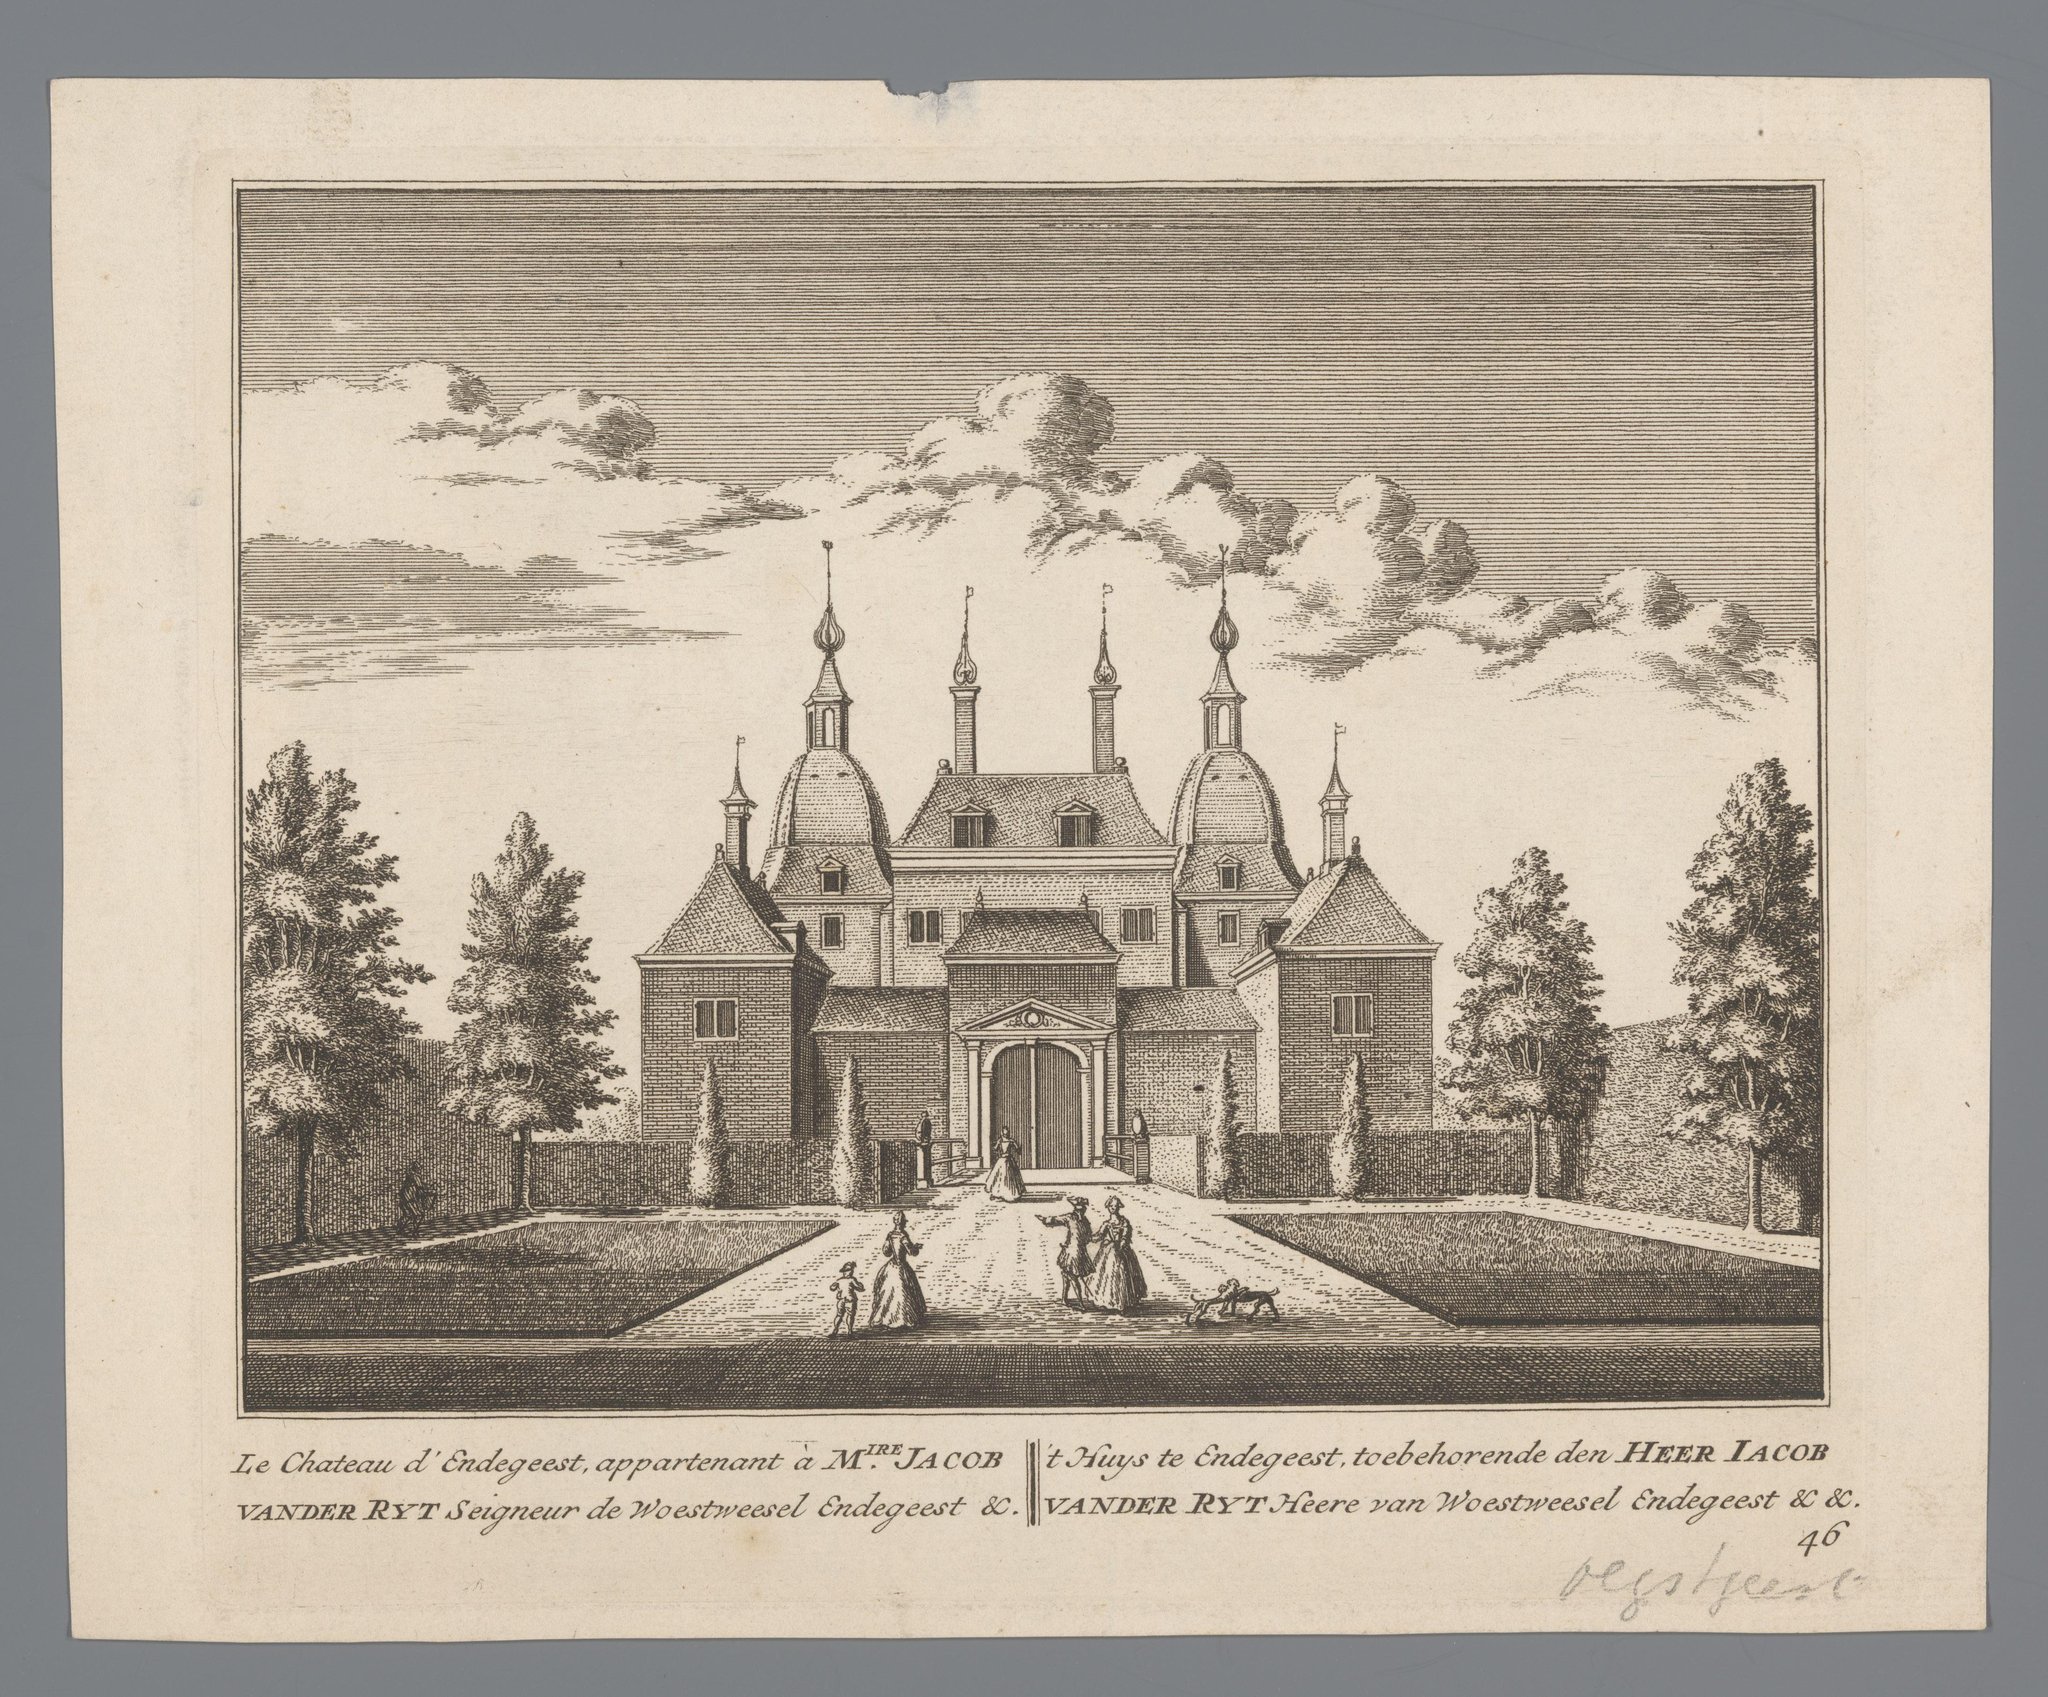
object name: book illustration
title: Le chateau d'Endegeest, appartenant à M.ire Jacob vander Ryt seigneur de Woestweesel Endegeest &c. / 't Huys te Endegeest, toebehorende den heer Jacob vander Ryt Heere van Woestweesel Endegeest &c.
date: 1731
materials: paper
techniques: engraving, etching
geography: amsterdam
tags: castle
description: Prent uit: Rademaker, Abraham. Rhynlands fraaiste gezichten (...). Amsterdam: Leonard Schenk, 1732, nr. 46.